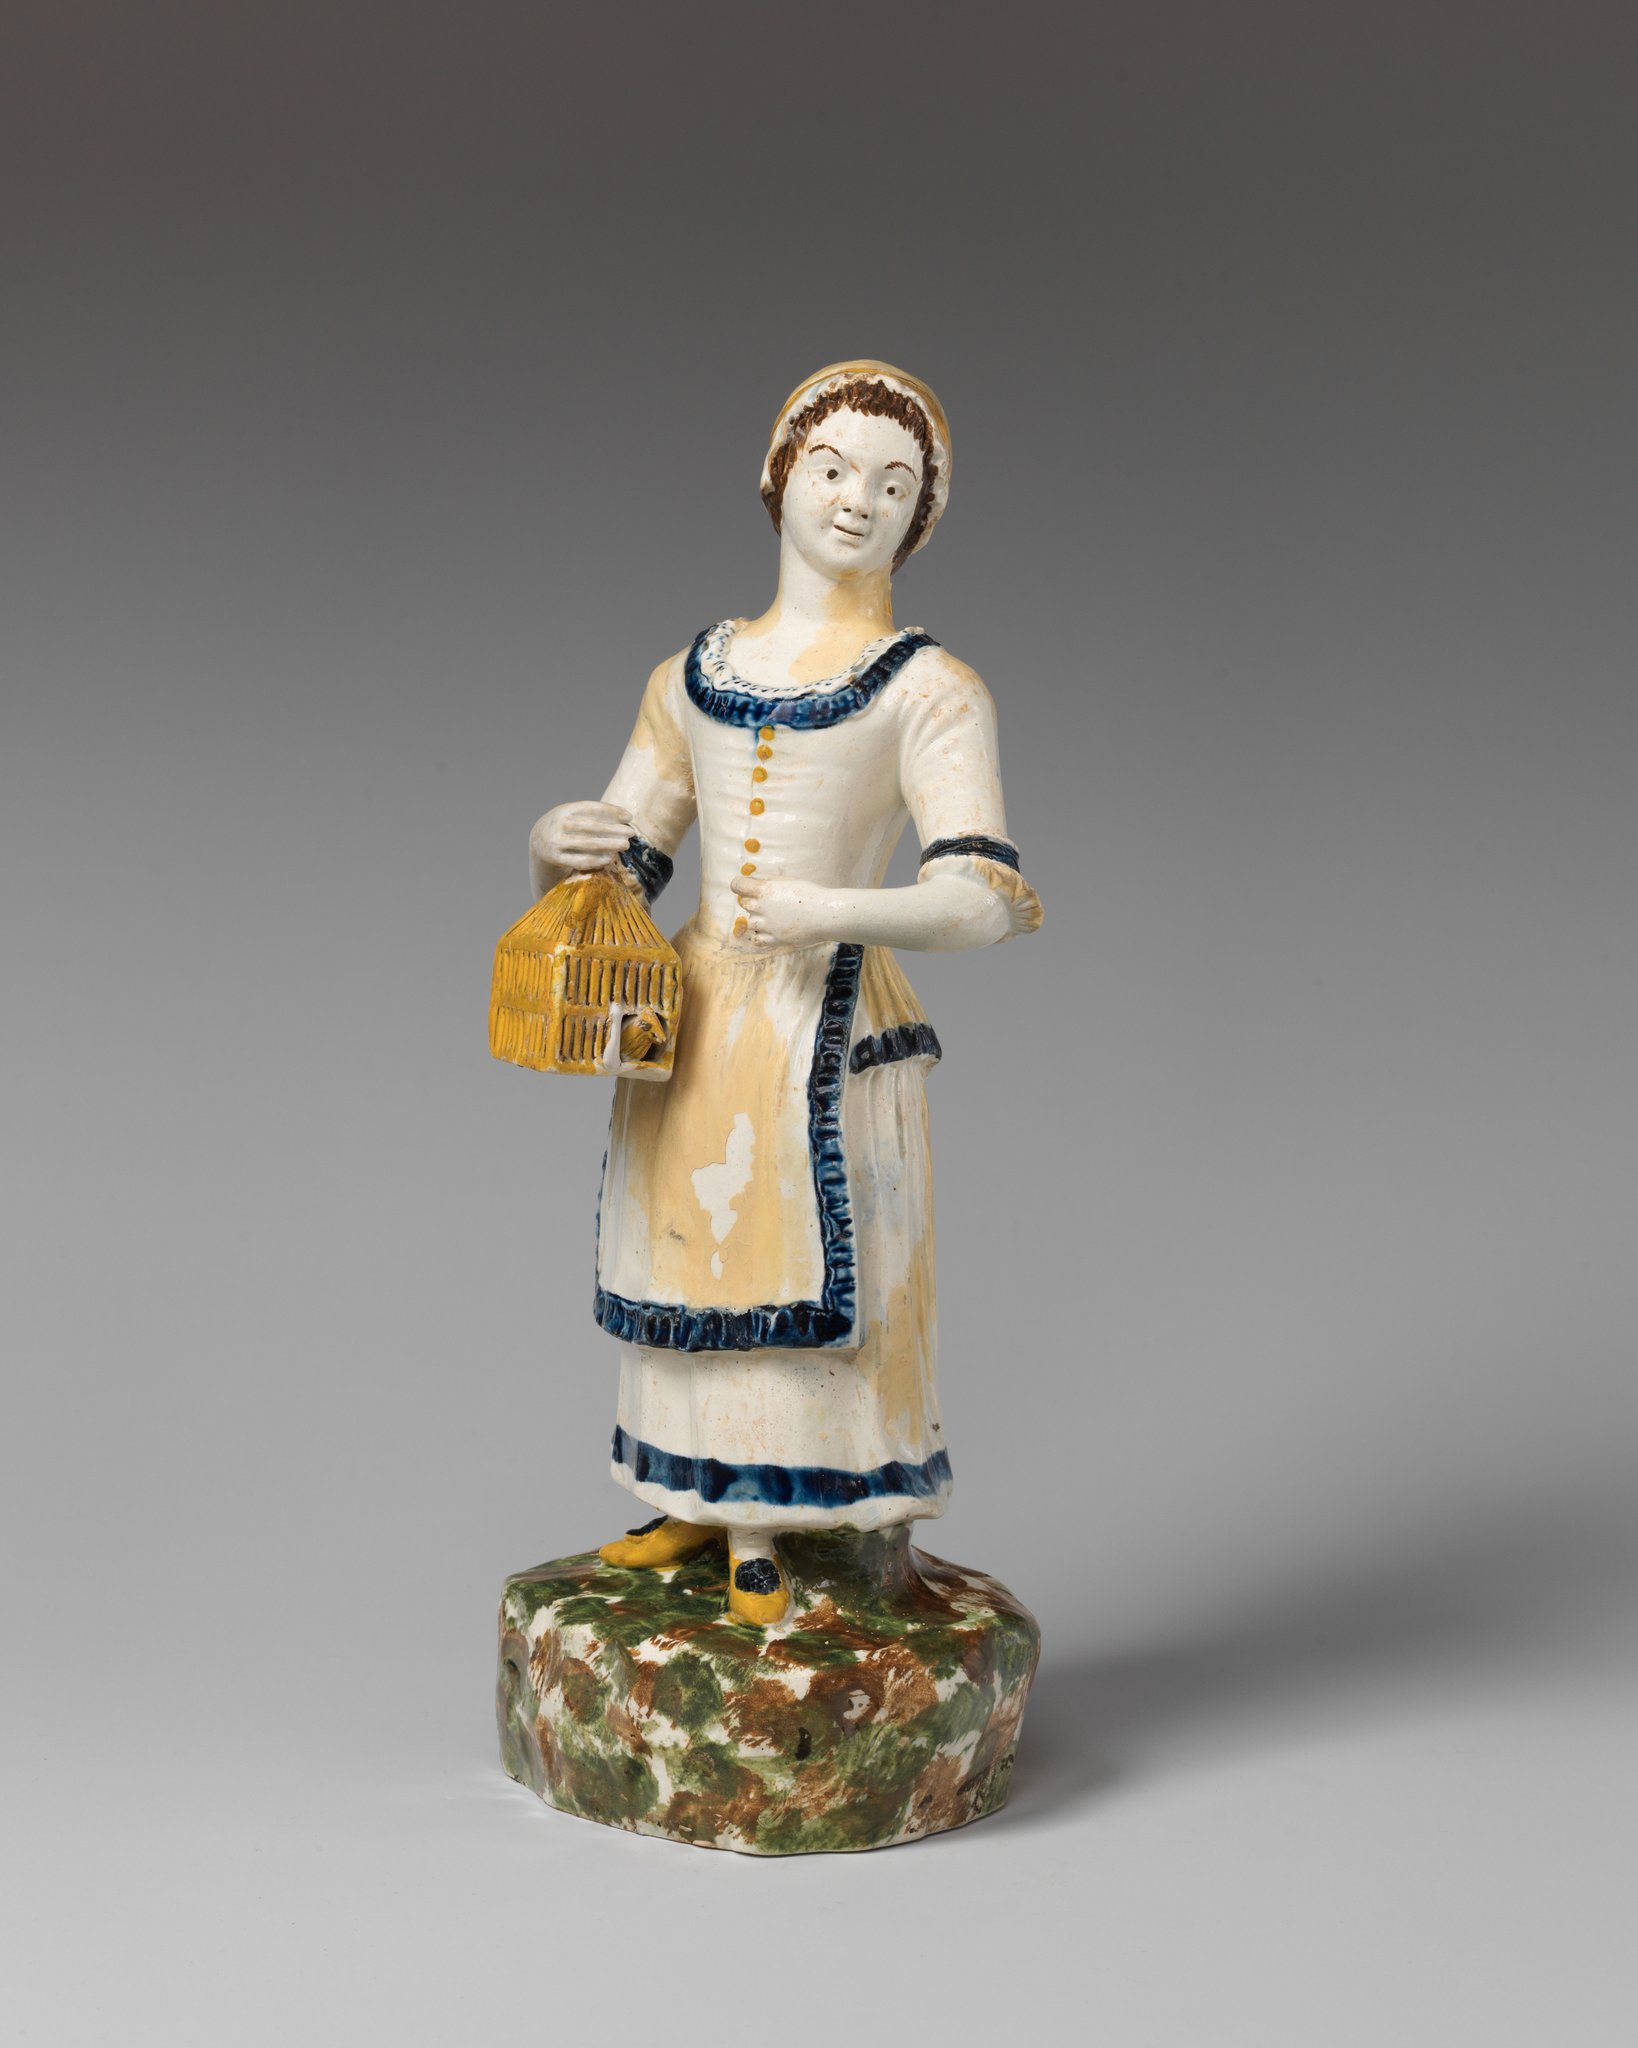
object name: figure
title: Girl (one of a pair)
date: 1780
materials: earthenware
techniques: glazing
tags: girls